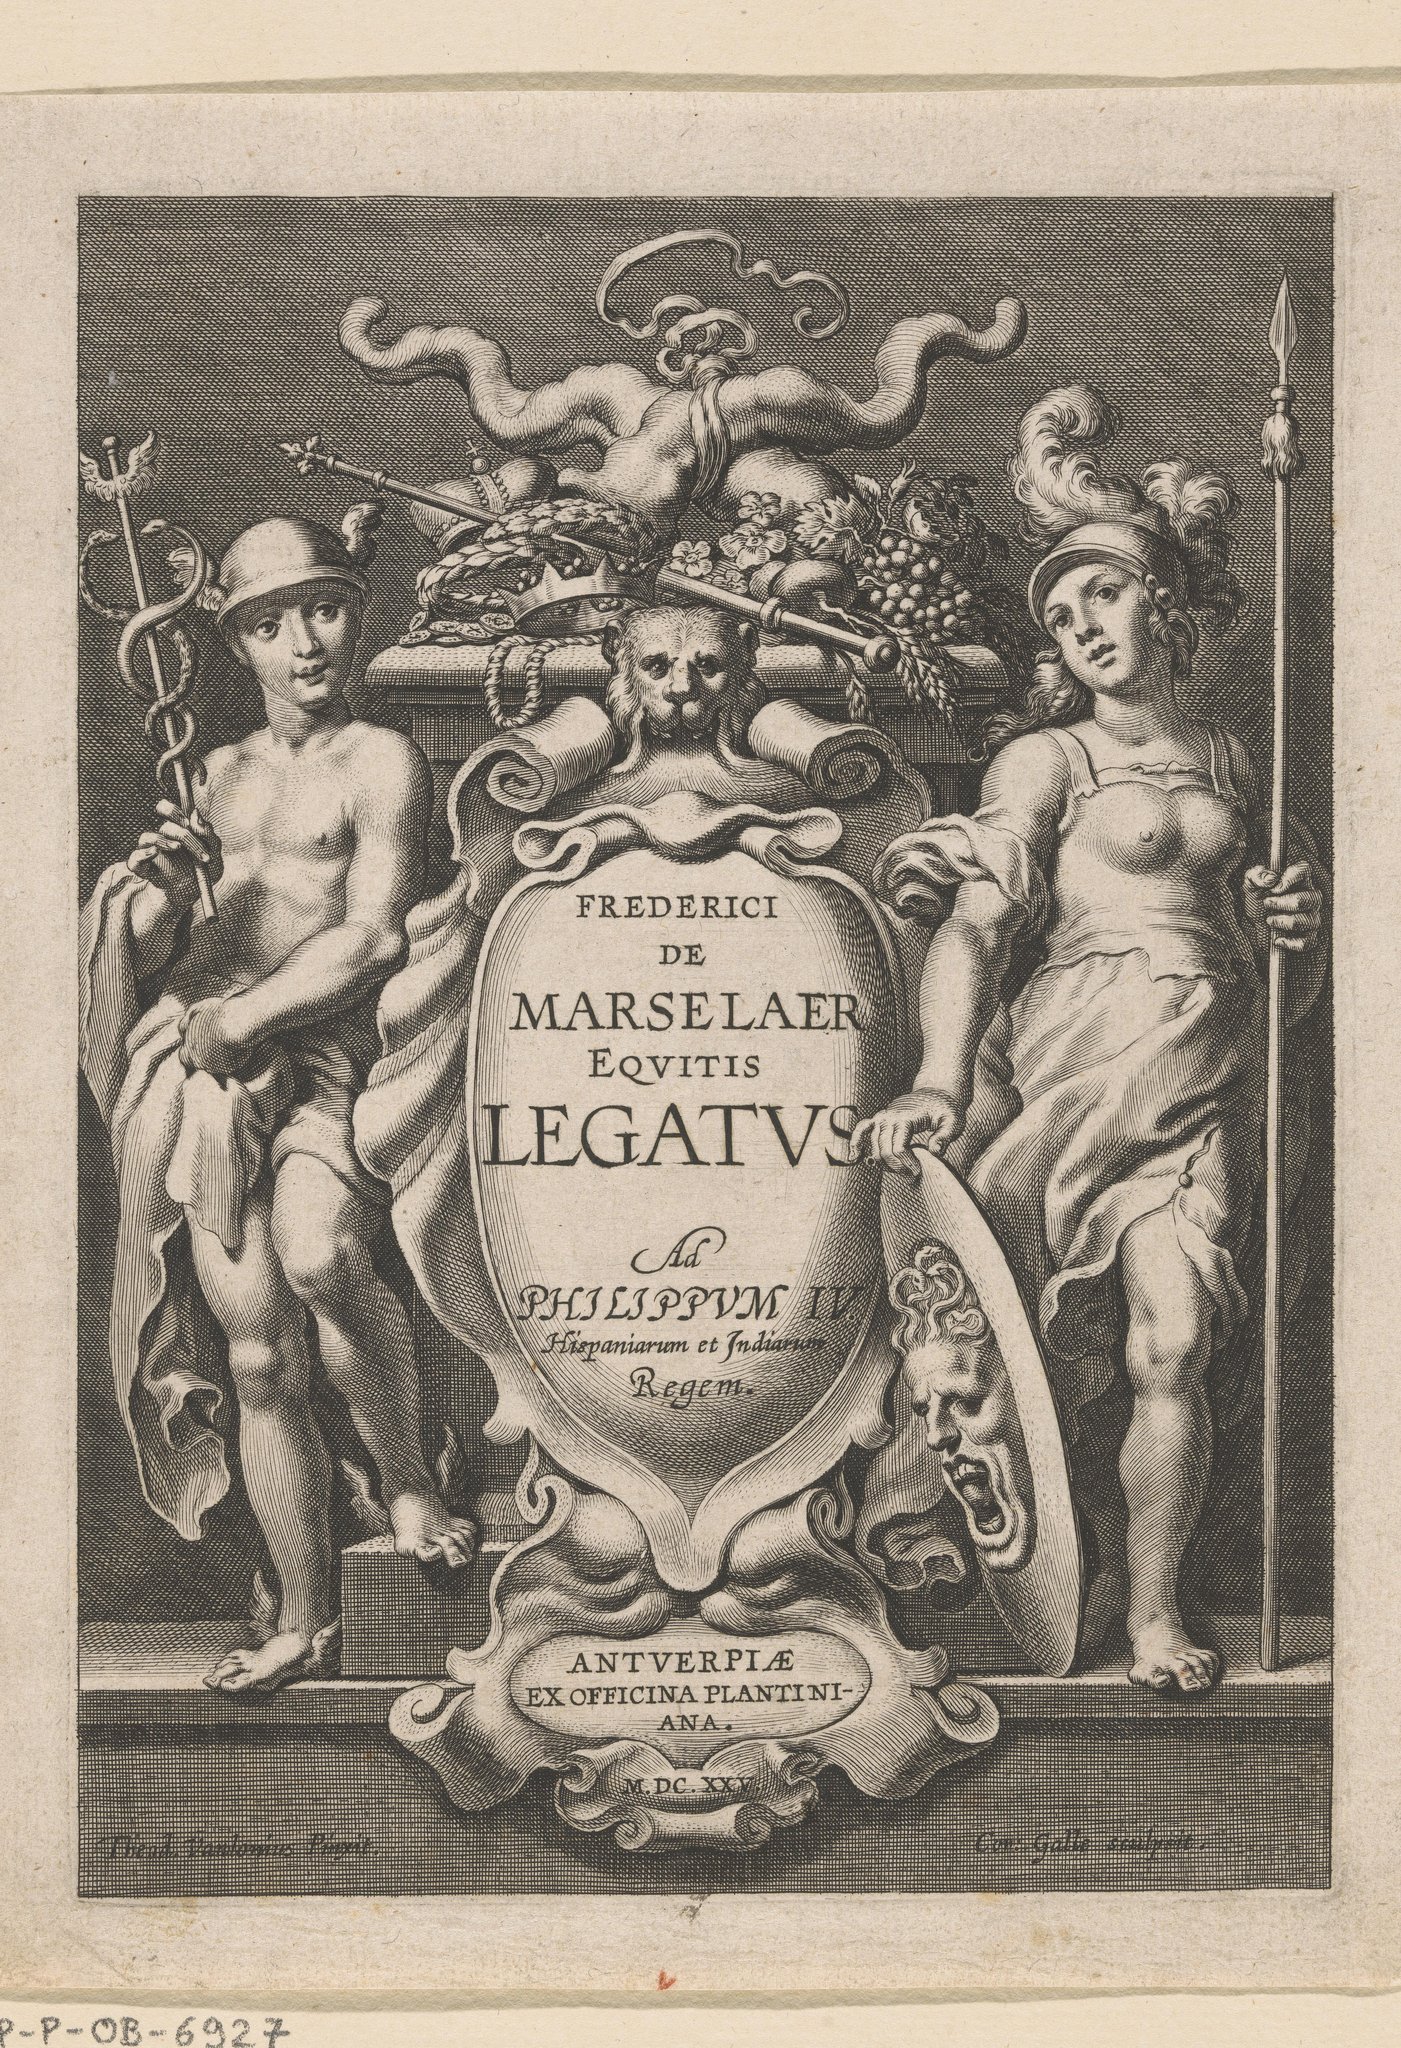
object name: print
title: Allegorische titelpagina met Mercurius en Minerva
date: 1625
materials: paper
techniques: engraving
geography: antwerp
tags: (story of) minerva (pallas, athena), (story of) mercury (hermes)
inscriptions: collector's mark: Lugt 240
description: Titelpagina van: Frederik de Marselaer, Equitis Legatus, 2e deel. Antwerpen: ex officina Plantiniana, 1626.